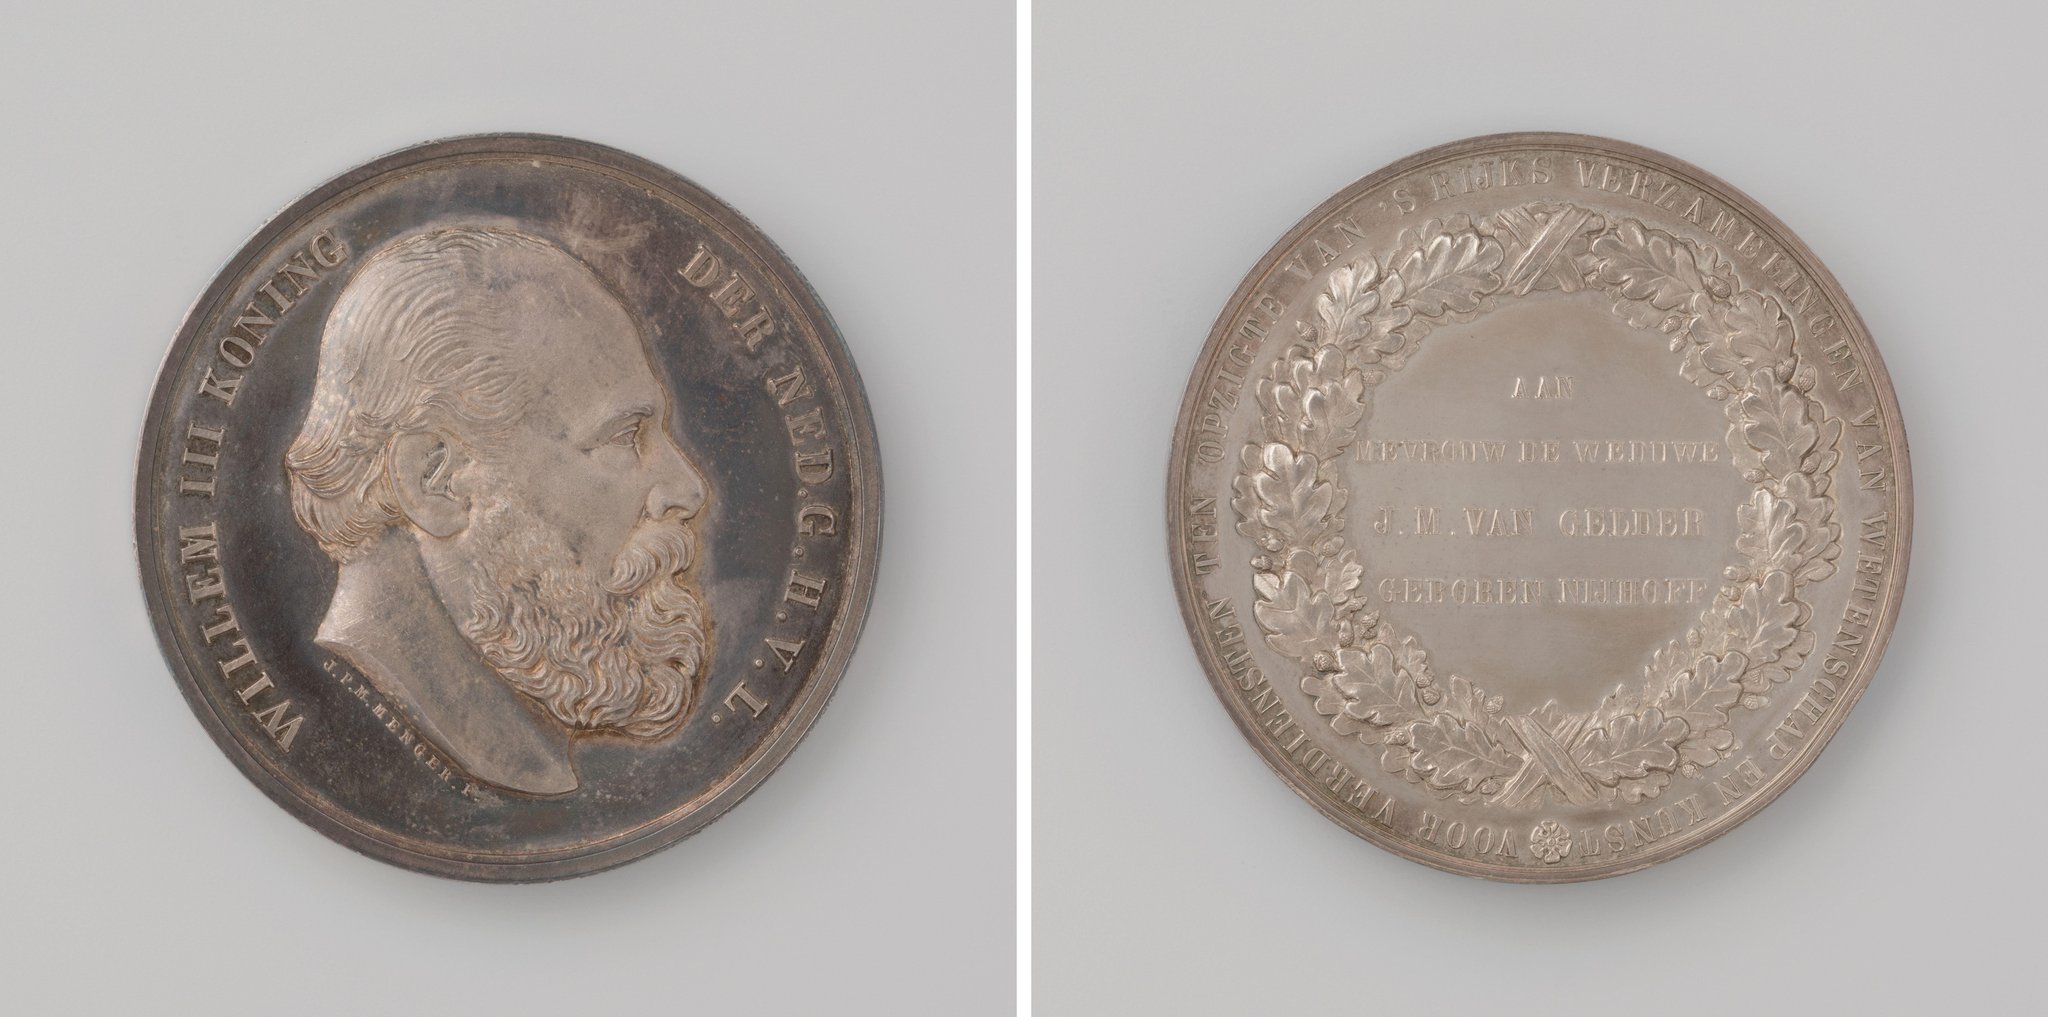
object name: medal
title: Medal of honour awarded to Mrs J.M. van Gelder-Nijhoff for bequeathing her husband’s collection of medals to the Dutch state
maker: johan philip mathias menger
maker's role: medailleur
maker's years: 1845-1905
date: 1877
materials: silver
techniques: striking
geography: utrecht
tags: brussels, willem iii (koning der nederlanden)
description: Zilveren penning. Voorzijde: borststuk man binnen omschrift. Keerzijde: opschrift binnen krans van eikeloof en omschrift